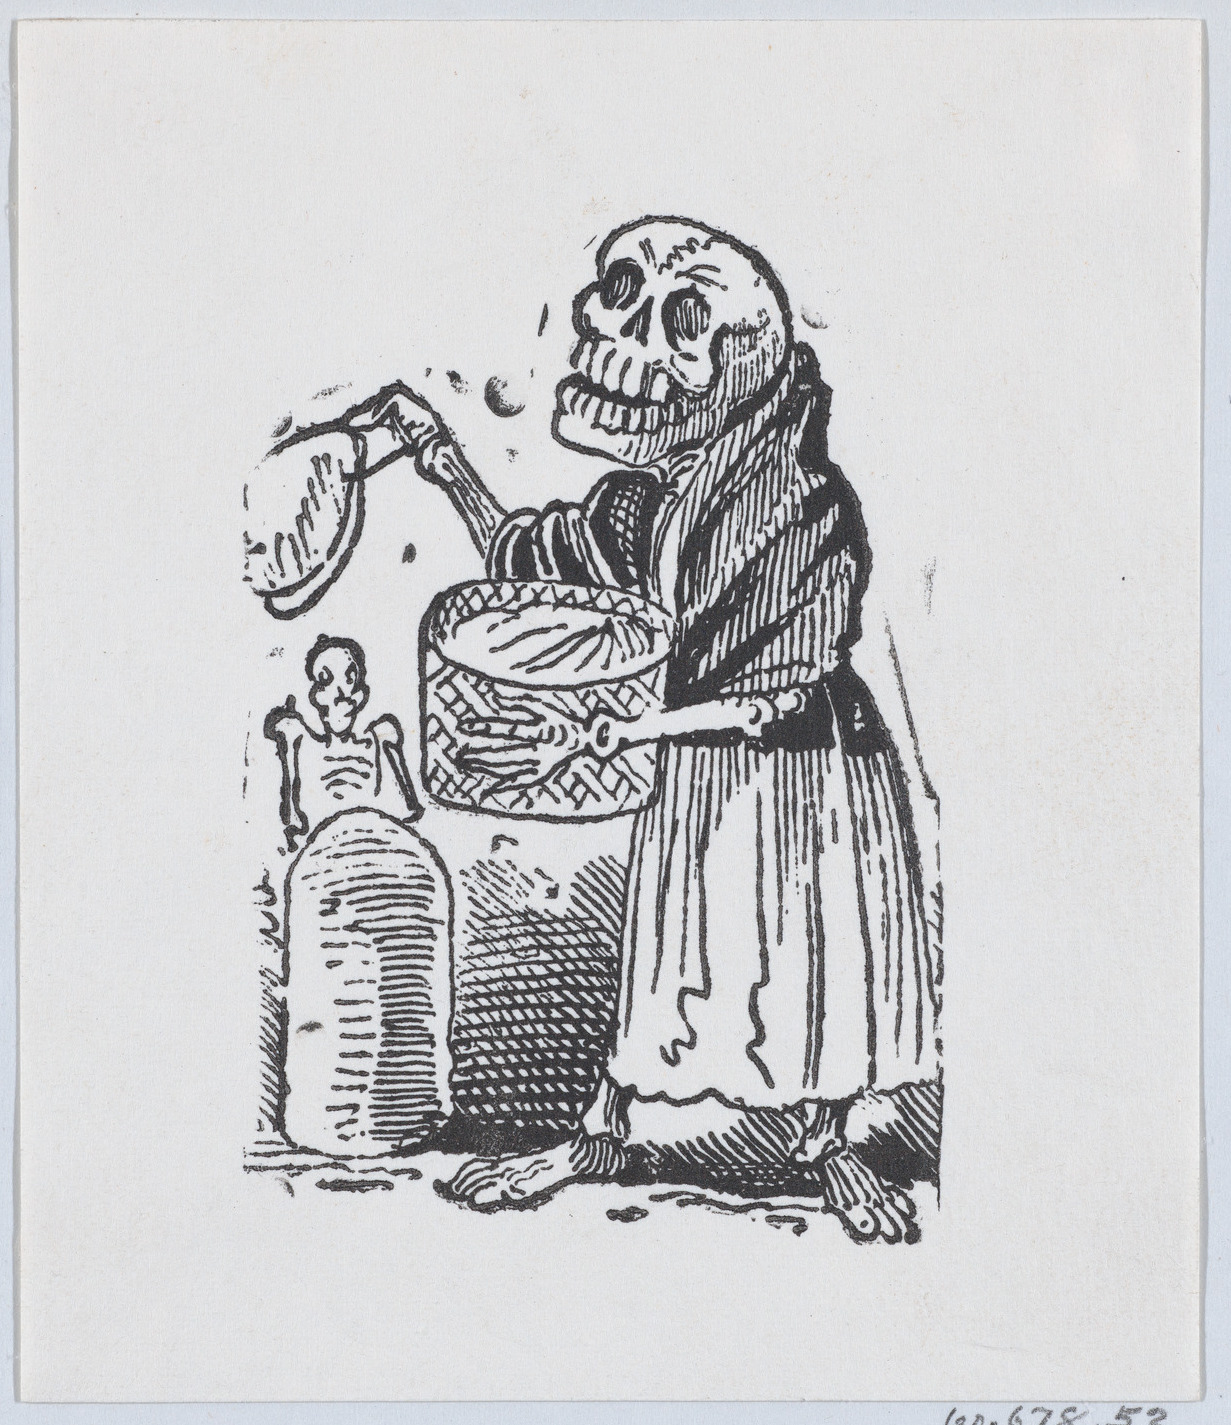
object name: print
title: A skeleton selling tortillas from a broadside entitled 'Una Calavera Chusca'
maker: josé guadalupe posada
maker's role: artist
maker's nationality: mexican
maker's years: 1852-1913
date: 1880-1910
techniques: lithography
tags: food,skeletons